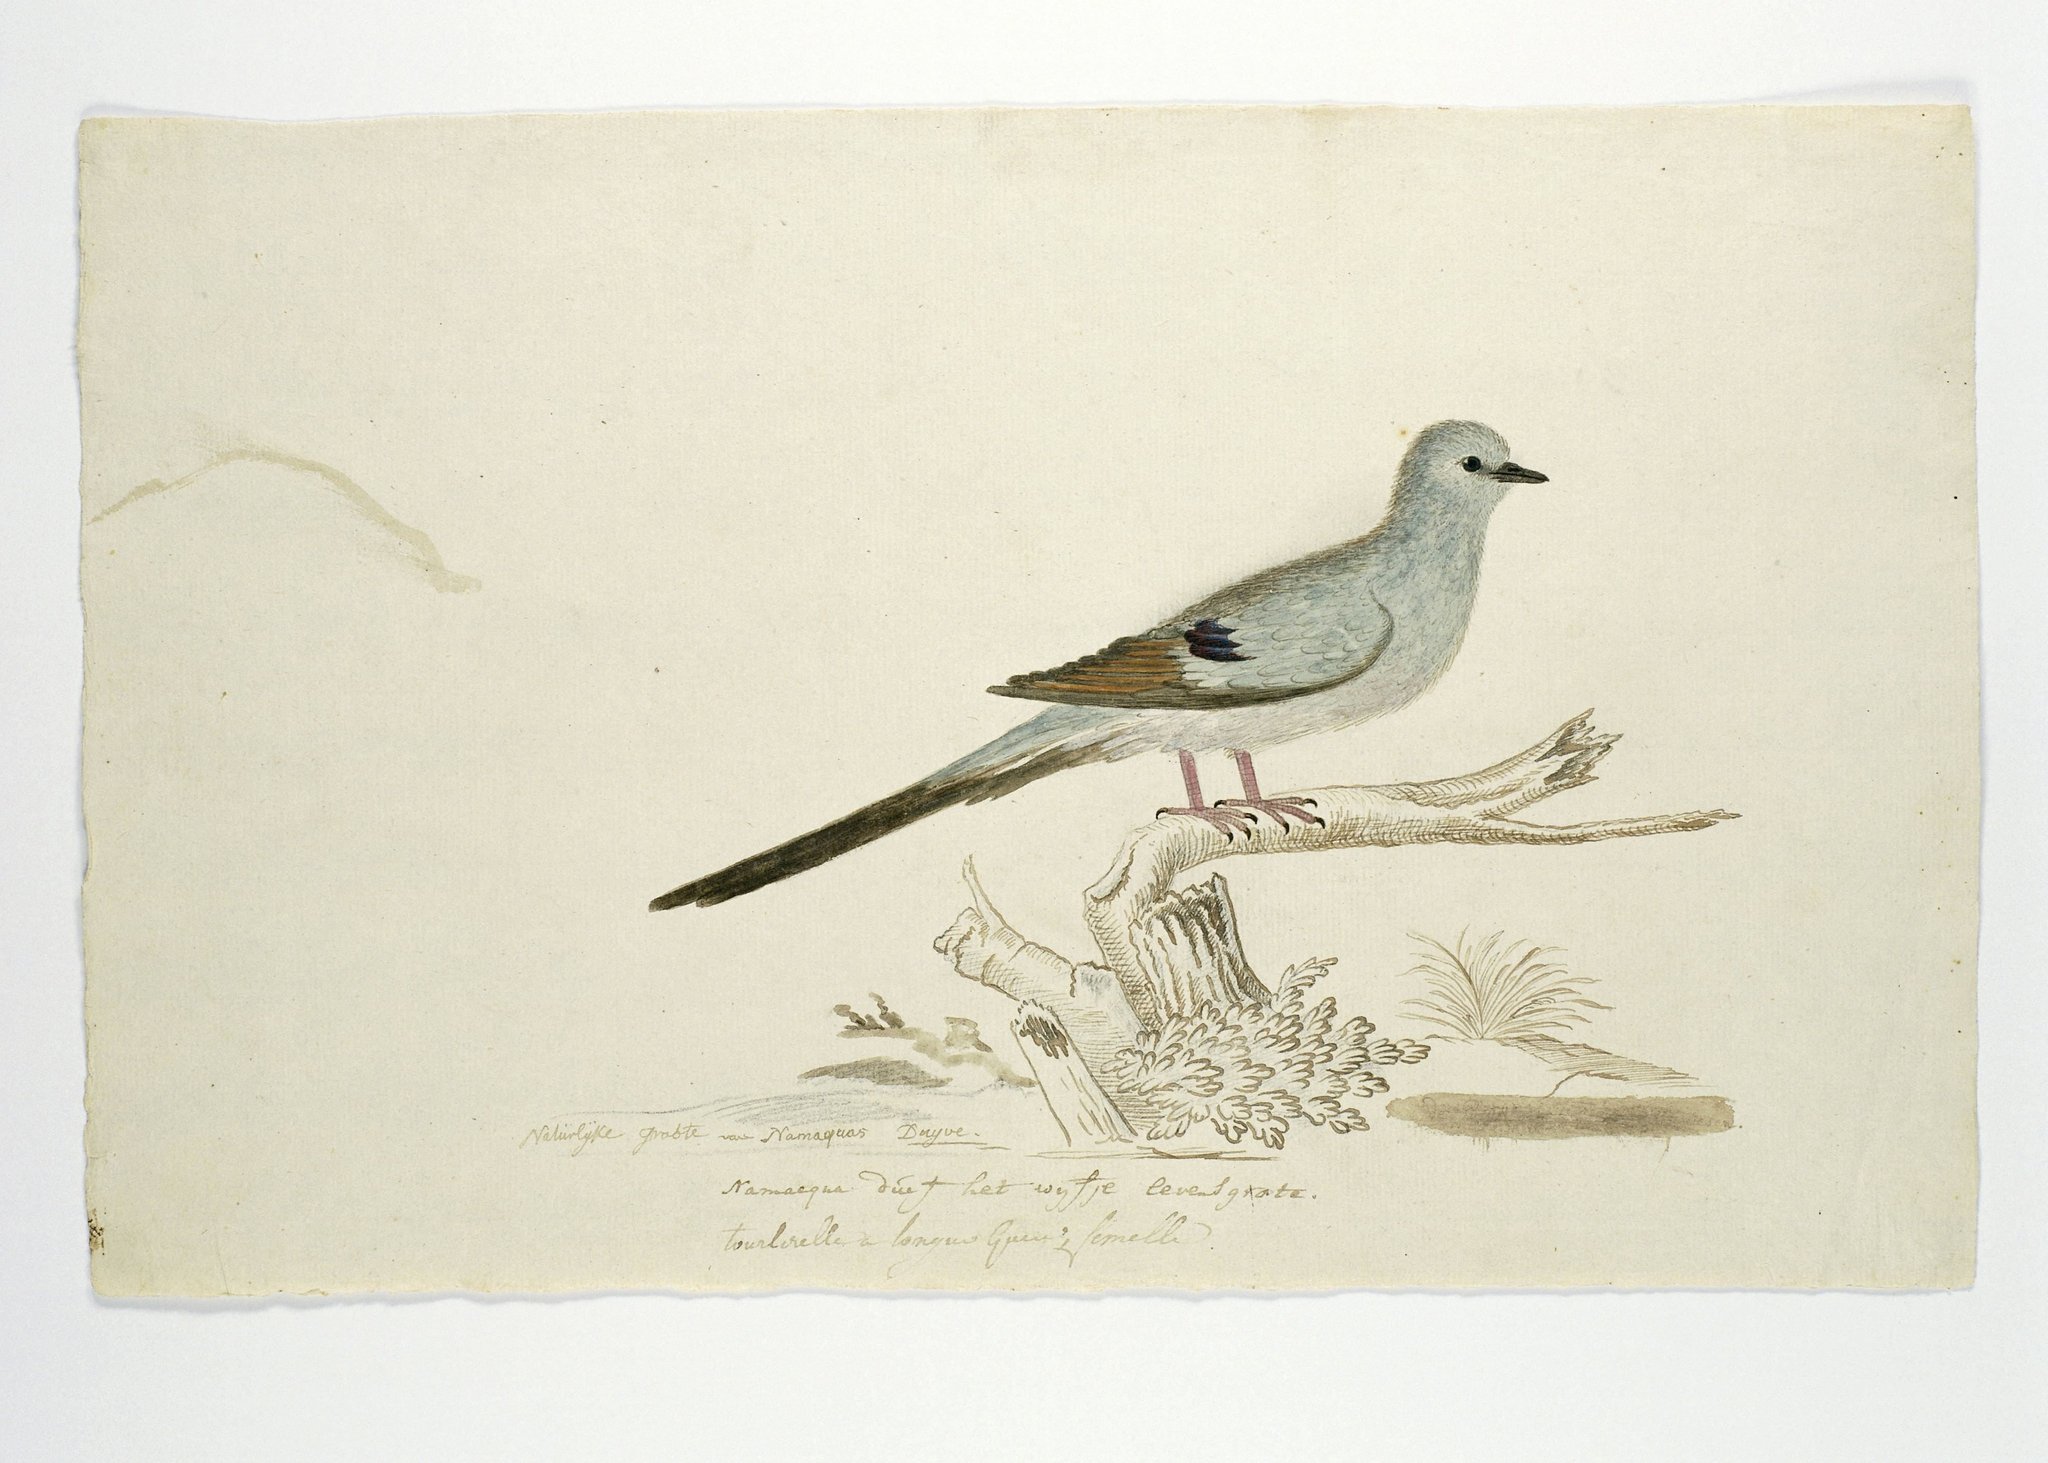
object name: drawing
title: Oena capensis (Namaqua dove)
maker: robert jacob gordon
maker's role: draughtsman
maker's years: 1743-1795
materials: chalk, paint, ink, paper, pencil, watercolor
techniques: brush, pen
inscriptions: annotation: ‘natürlijke groote van Namaquas Duyve; Namacqua duif het wijfje levensgrote. / tourterelle a longue queue femelle.’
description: Vogelstudie: Namaqua duif (Oena capensis), het wijfje; op ware grootte.